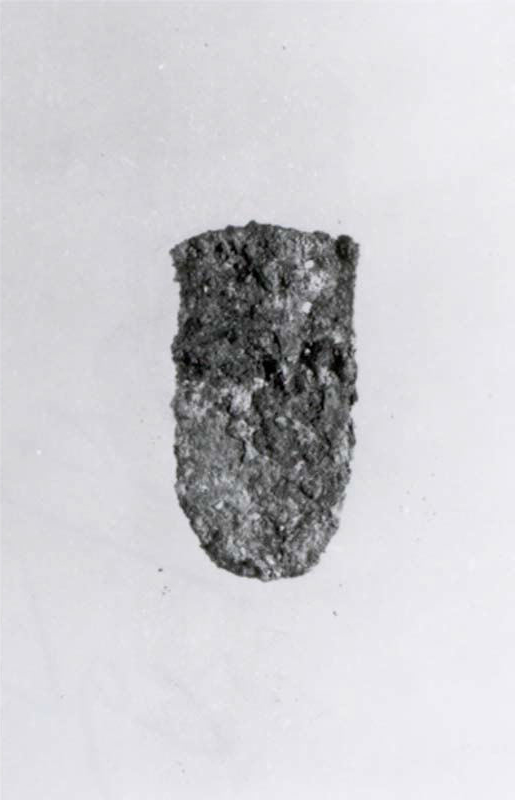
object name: armor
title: Armor plate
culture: assyrian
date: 734-601 BCE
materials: iron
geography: mesopotamia